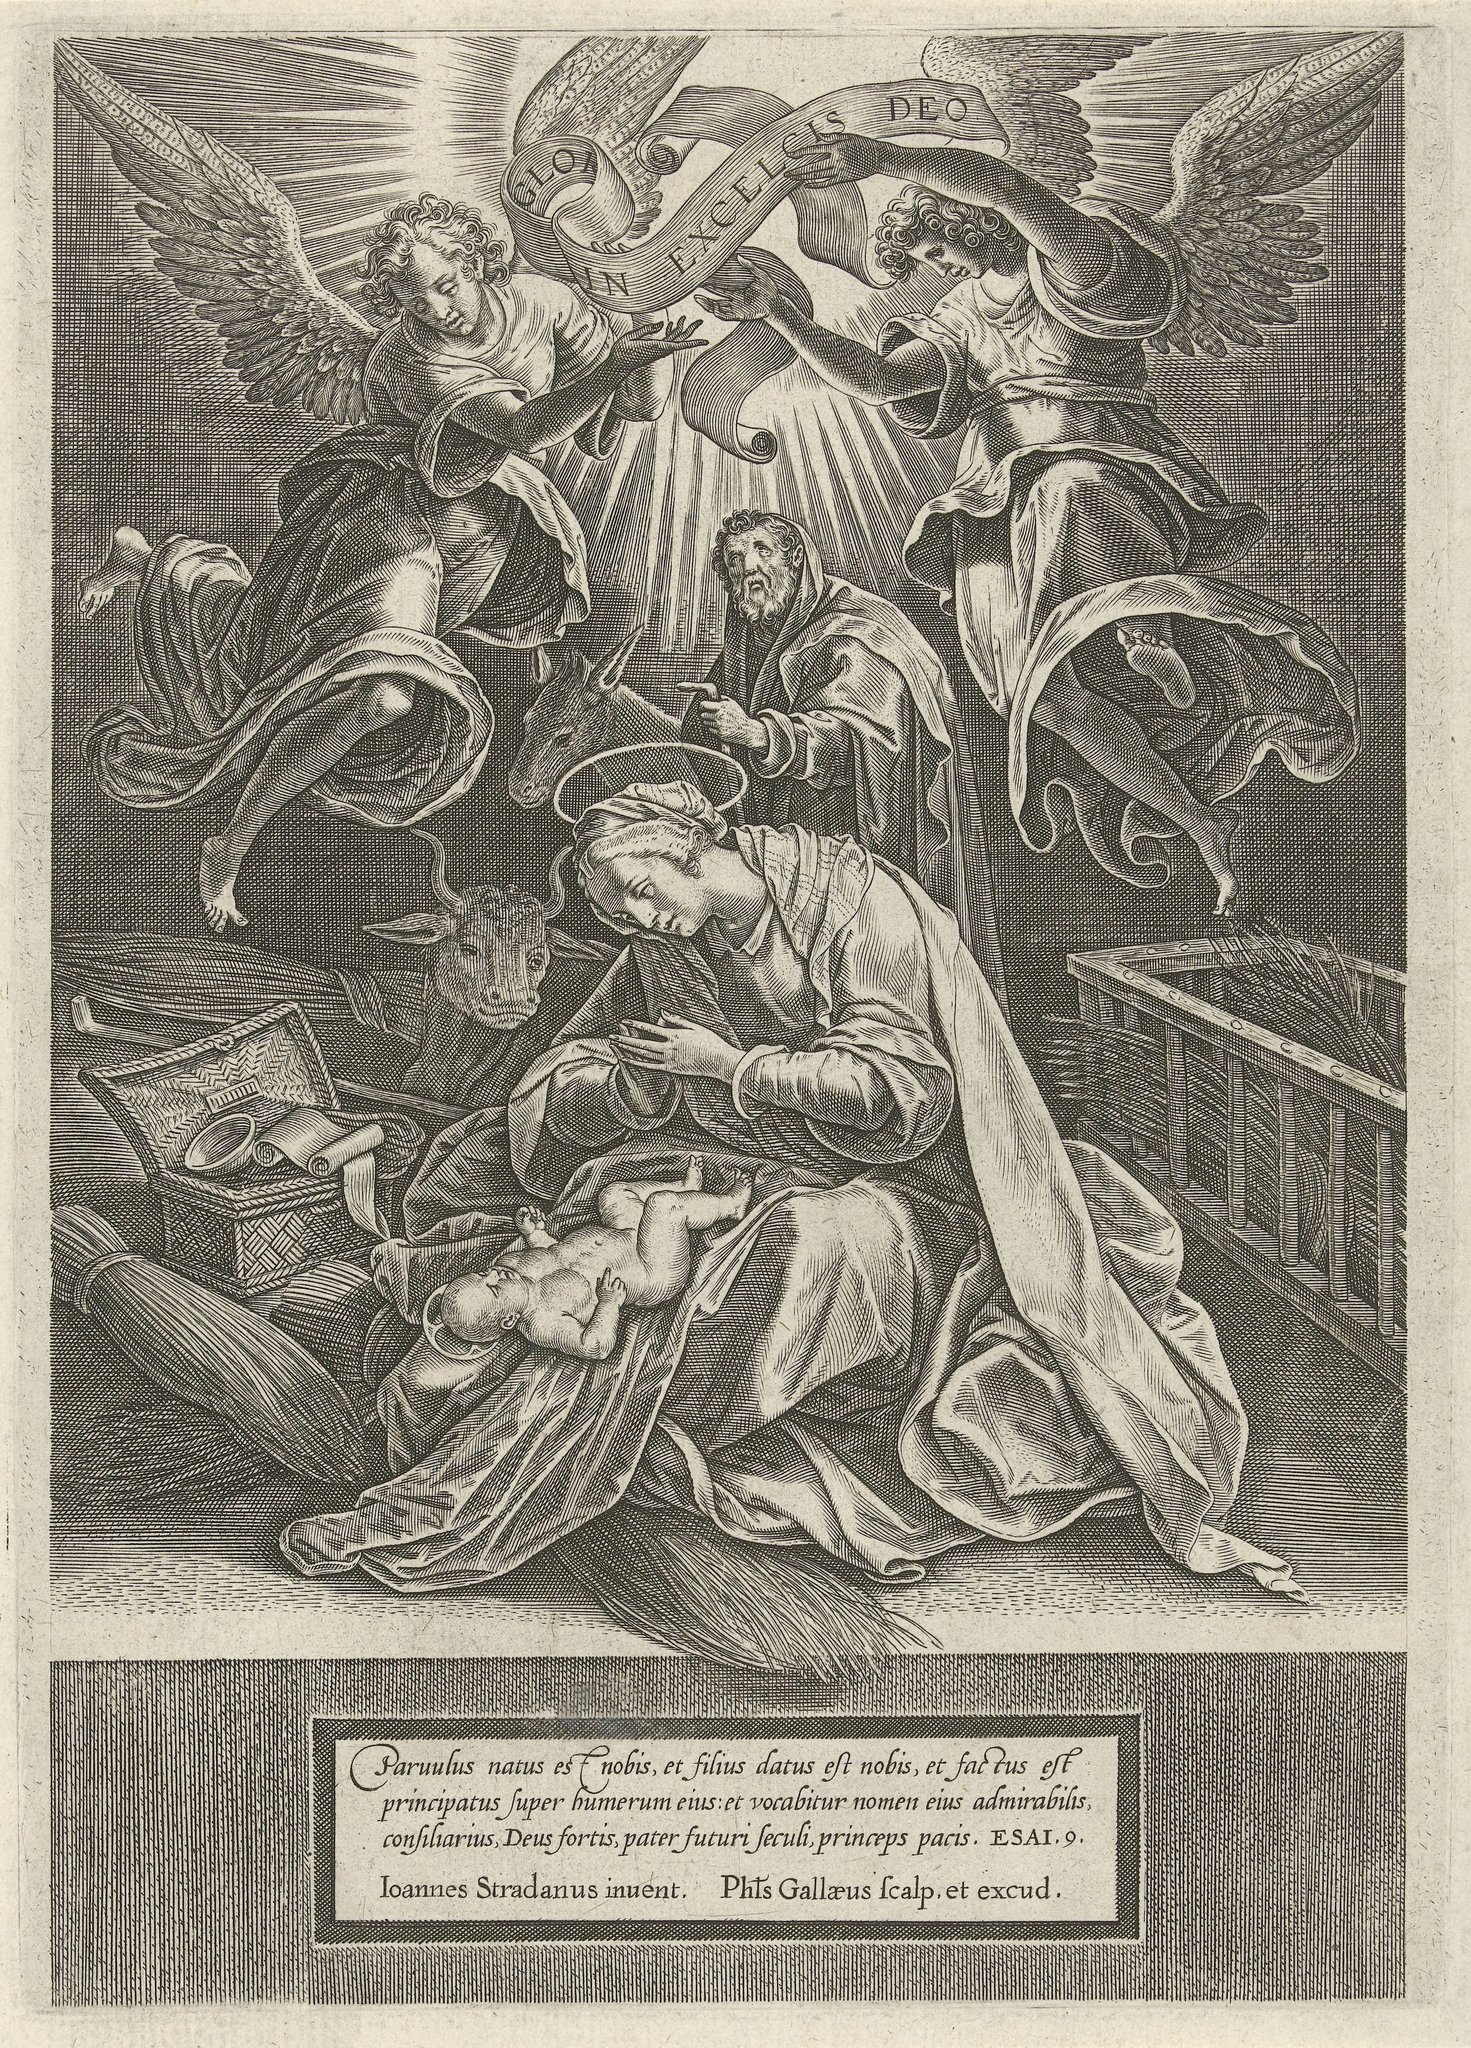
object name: print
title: Geboorte van Christus.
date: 1547-1612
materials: paper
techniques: engraving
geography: antwerp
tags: adoration of the christ-child ~ christ's birth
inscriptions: collector's mark: Lugt 2228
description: Maria met het Christuskind op haar schoot. Boven haar zweven twee engelen, die een banderol vasthouden waarop "Gloria in excelsis deo" staat. Naast de Maagd Maria de kribbe. In de achtergrond Jozef en de os en de ezel. De prent heeft een Latijns onderschrift.